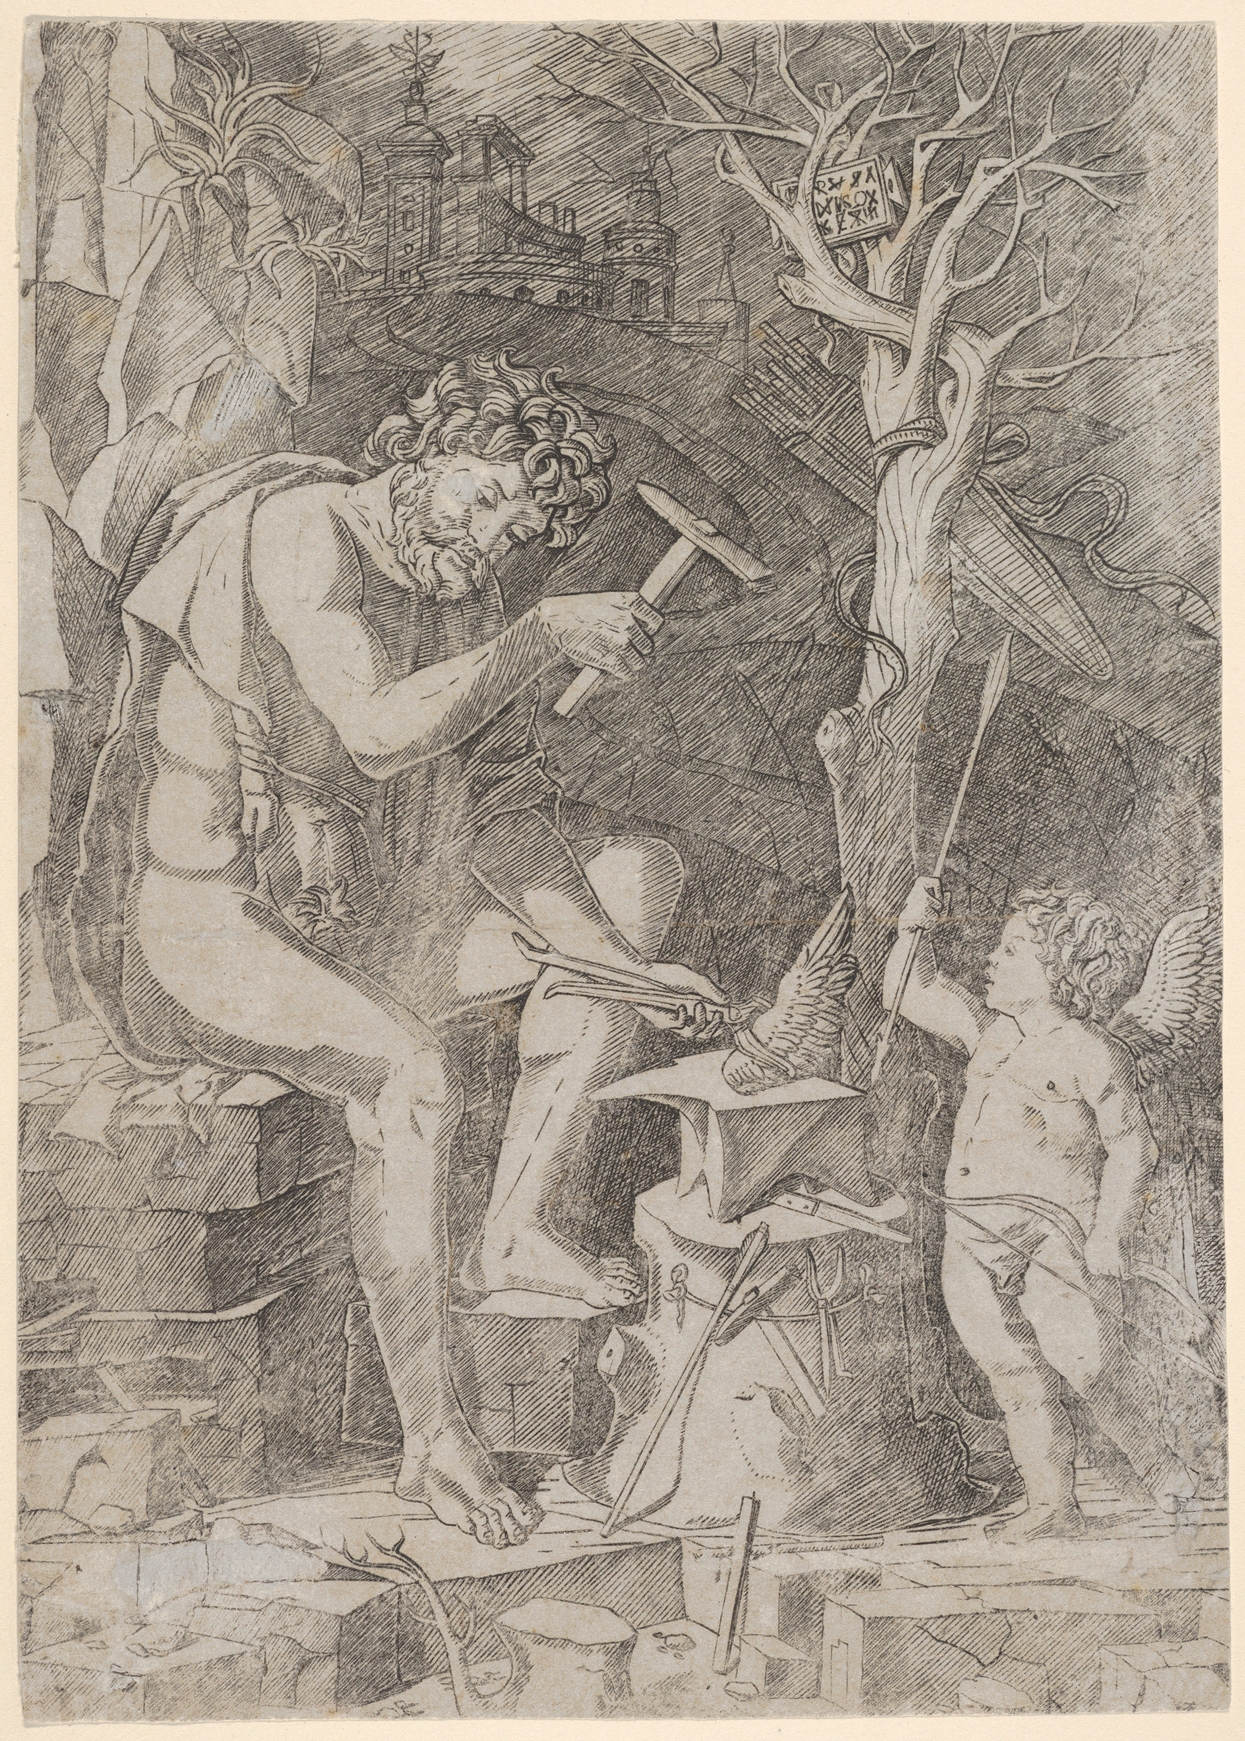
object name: print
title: Vulcan seated forging Cupid's wing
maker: nicoletto da modena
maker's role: artist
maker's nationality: italian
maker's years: 1500-1520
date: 1500-1510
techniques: engraving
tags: cupid,vulcan